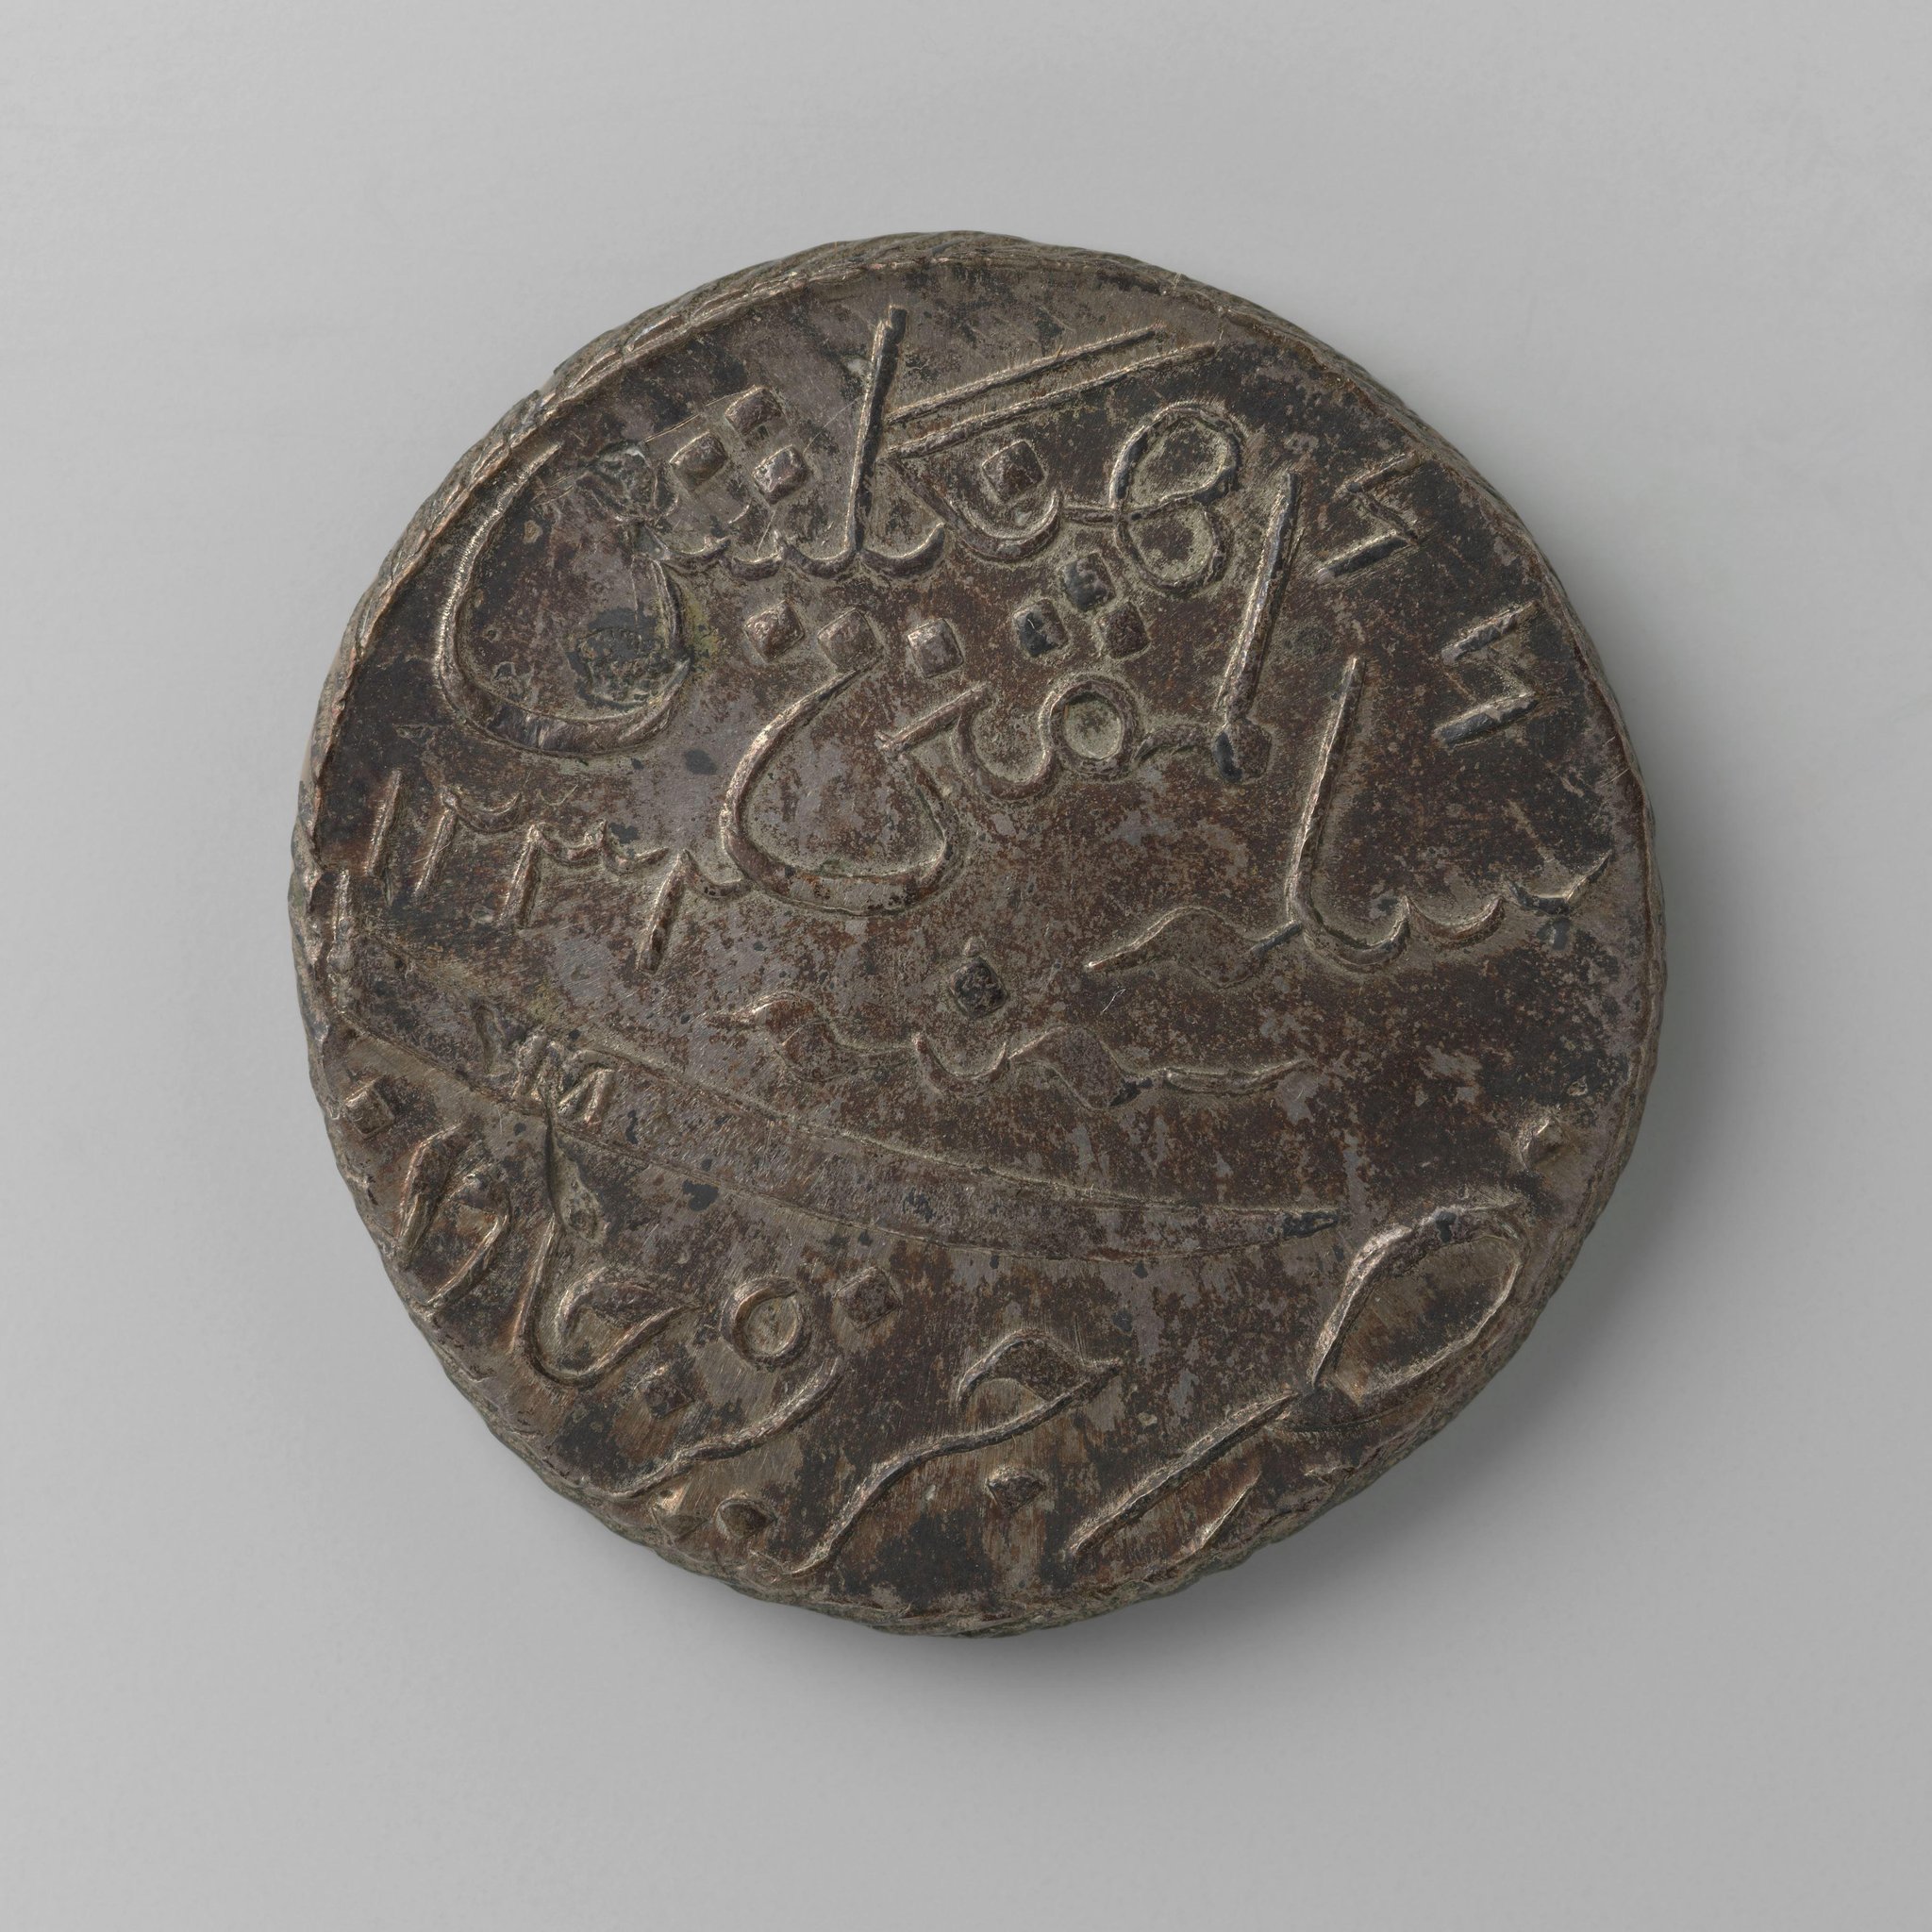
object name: coin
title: Zilveren ropij voor Nederlands Indië tijdens Brits bestuur, 1816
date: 1816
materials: silver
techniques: striking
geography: surabaya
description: Zilveren munt. Voorzijde: drieregelig opschrift in het Javaans met op opnderste regel jaartal. Daarboven muntteken en daaronder muntmeesterteken Z [=muntmeester Zwekkert]. Keerzijde: vijfregelig opschrift in het Arabisch, waariin jaartal in Islamitische jaartelling. Latijnse letter M op Arabische letter b van zarb. Kabelrand.